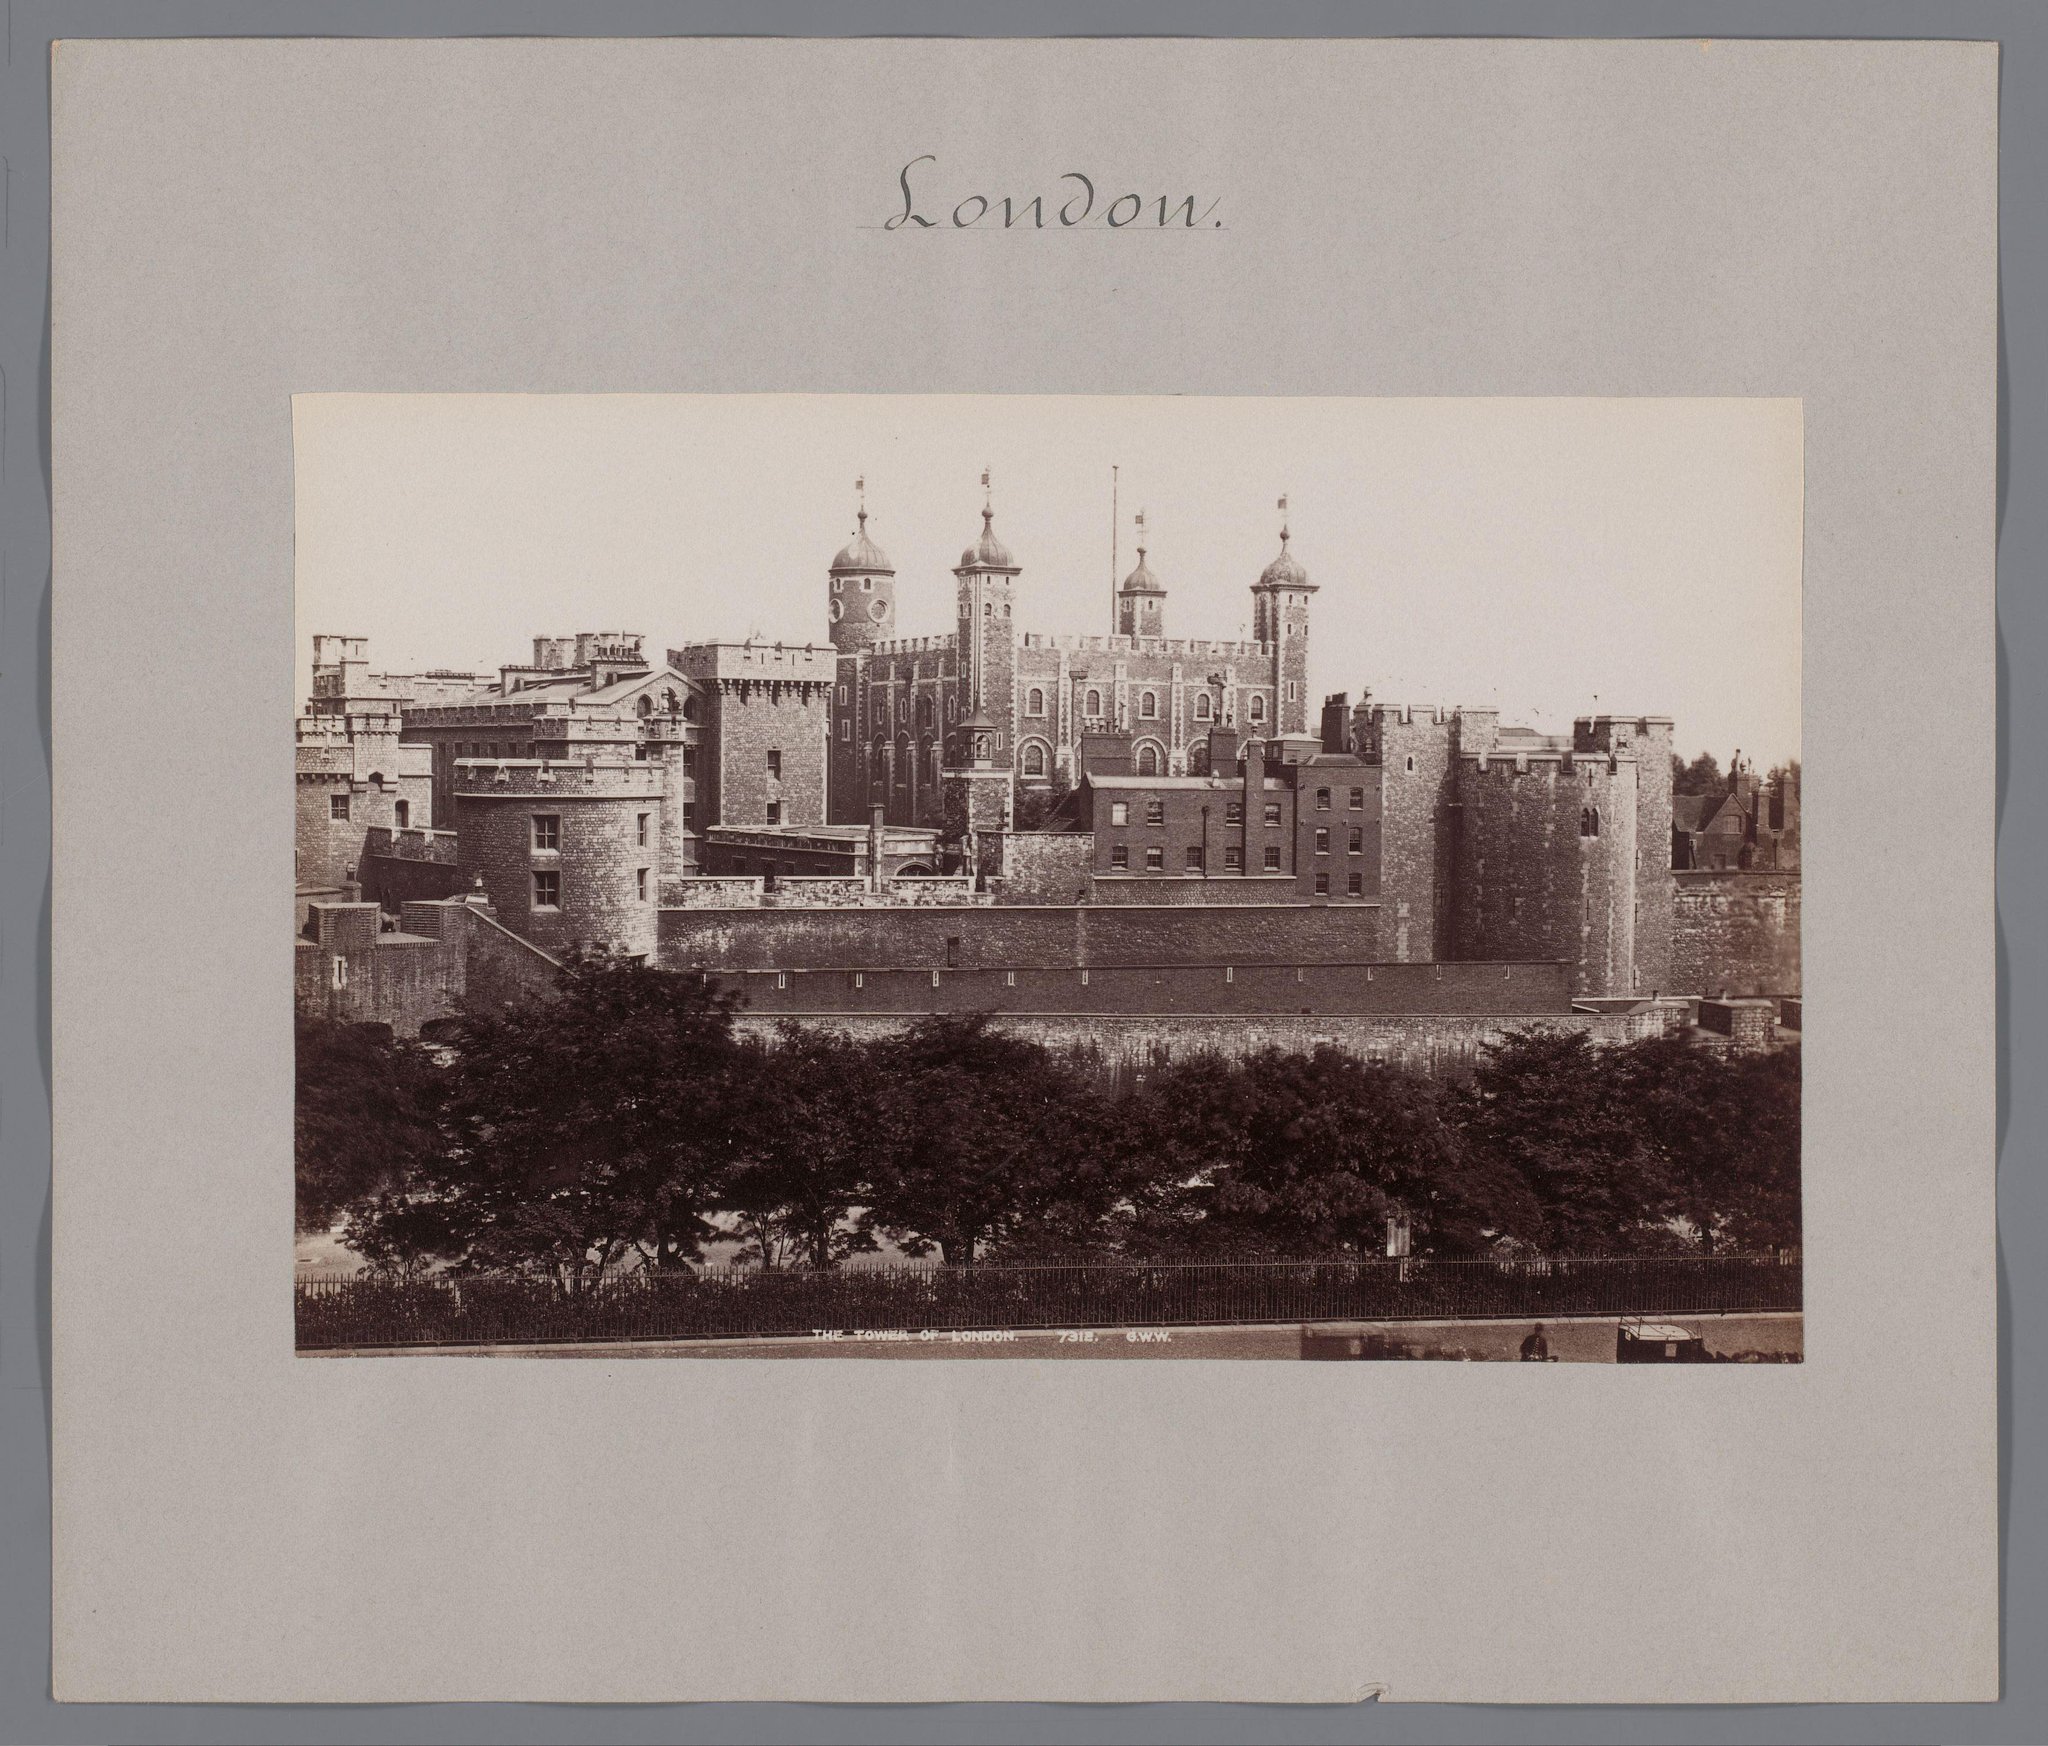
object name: album leaf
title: The Tower of London, Londen, Engeland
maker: george washington wilson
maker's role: publisher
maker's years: 1823-1893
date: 1880-1890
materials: cardboard, paper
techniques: albumen print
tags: tower of london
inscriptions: inscription: ‘The Tower of Londen 7312. G.W.W.’, inscription: ‘London.’